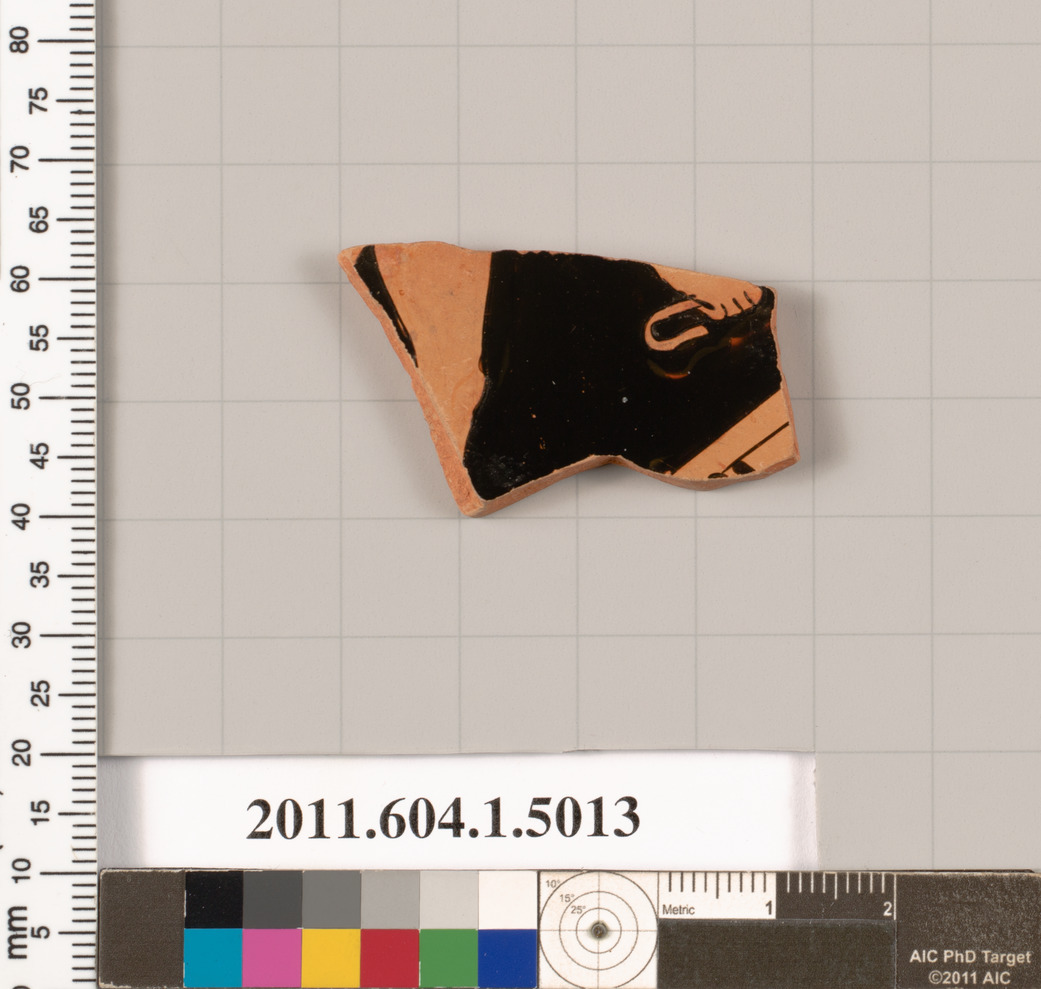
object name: kylix fragment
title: Terracotta fragment of a kylix (drinking cup)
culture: greek, attic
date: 500-476 BCE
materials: terracotta